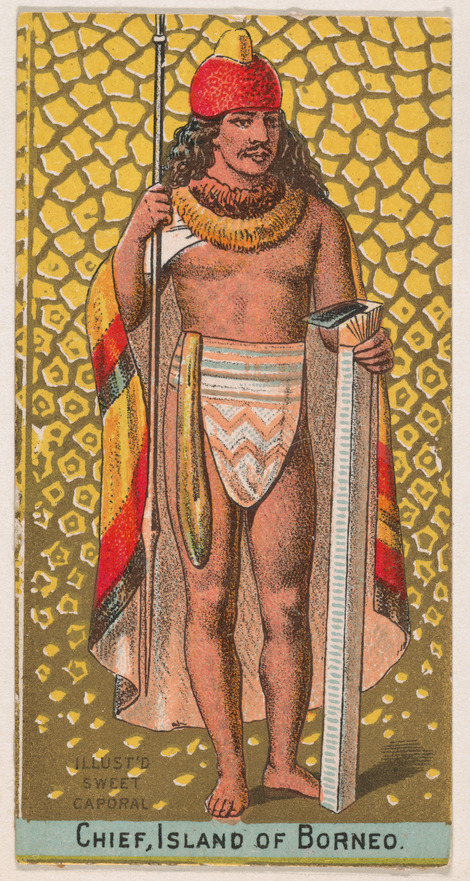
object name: print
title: Chief, Island of Borneo, from the Military Series (N224) issued by Kinney Tobacco Company to promote Sweet Caporal Cigarettes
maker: kinney brothers tobacco company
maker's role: publisher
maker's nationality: american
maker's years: 1869-2011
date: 1888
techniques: color lithograph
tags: military,men